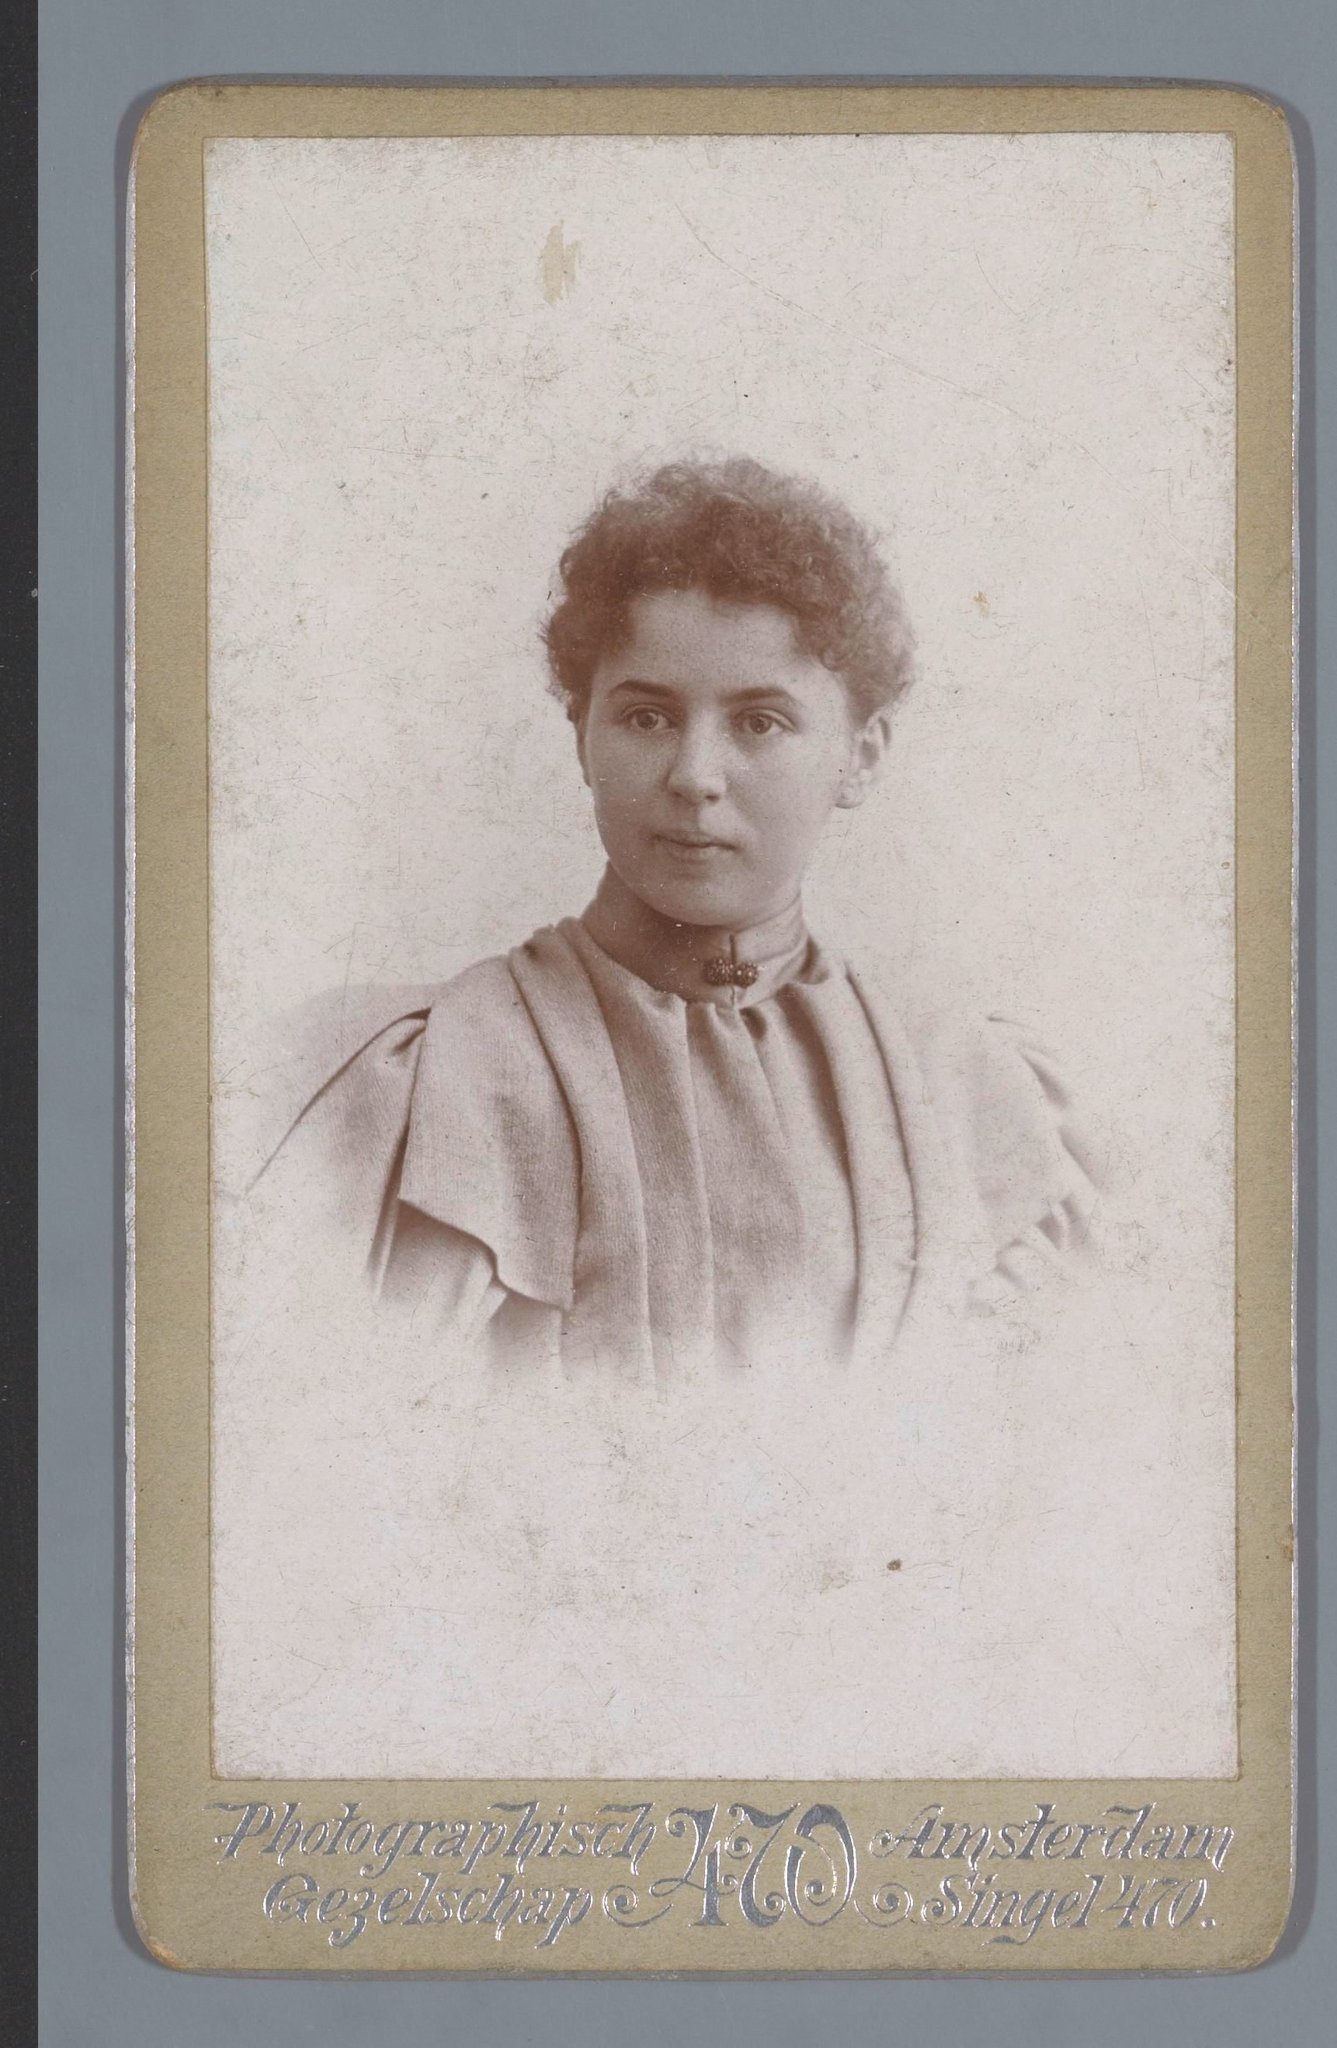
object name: photograph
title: Portret van een onbekende vrouw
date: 1895-1910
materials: cardboard, paper, photographic support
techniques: daylight paper print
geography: amsterdam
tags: adult woman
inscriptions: name: ‘Photographisch Gezelschap 470 Amsterdam Singel 470.’, name: ‘Trapp & Münch, Berlin, W’, name: ‘Photographisch Gezelschap Singel 470 boven de Amsterdamsche Rijtuig Maatschappij Specialiteit in reproductieen en vergrootingen. De platen blijven ter nabestelling bewaard. No. 9147’